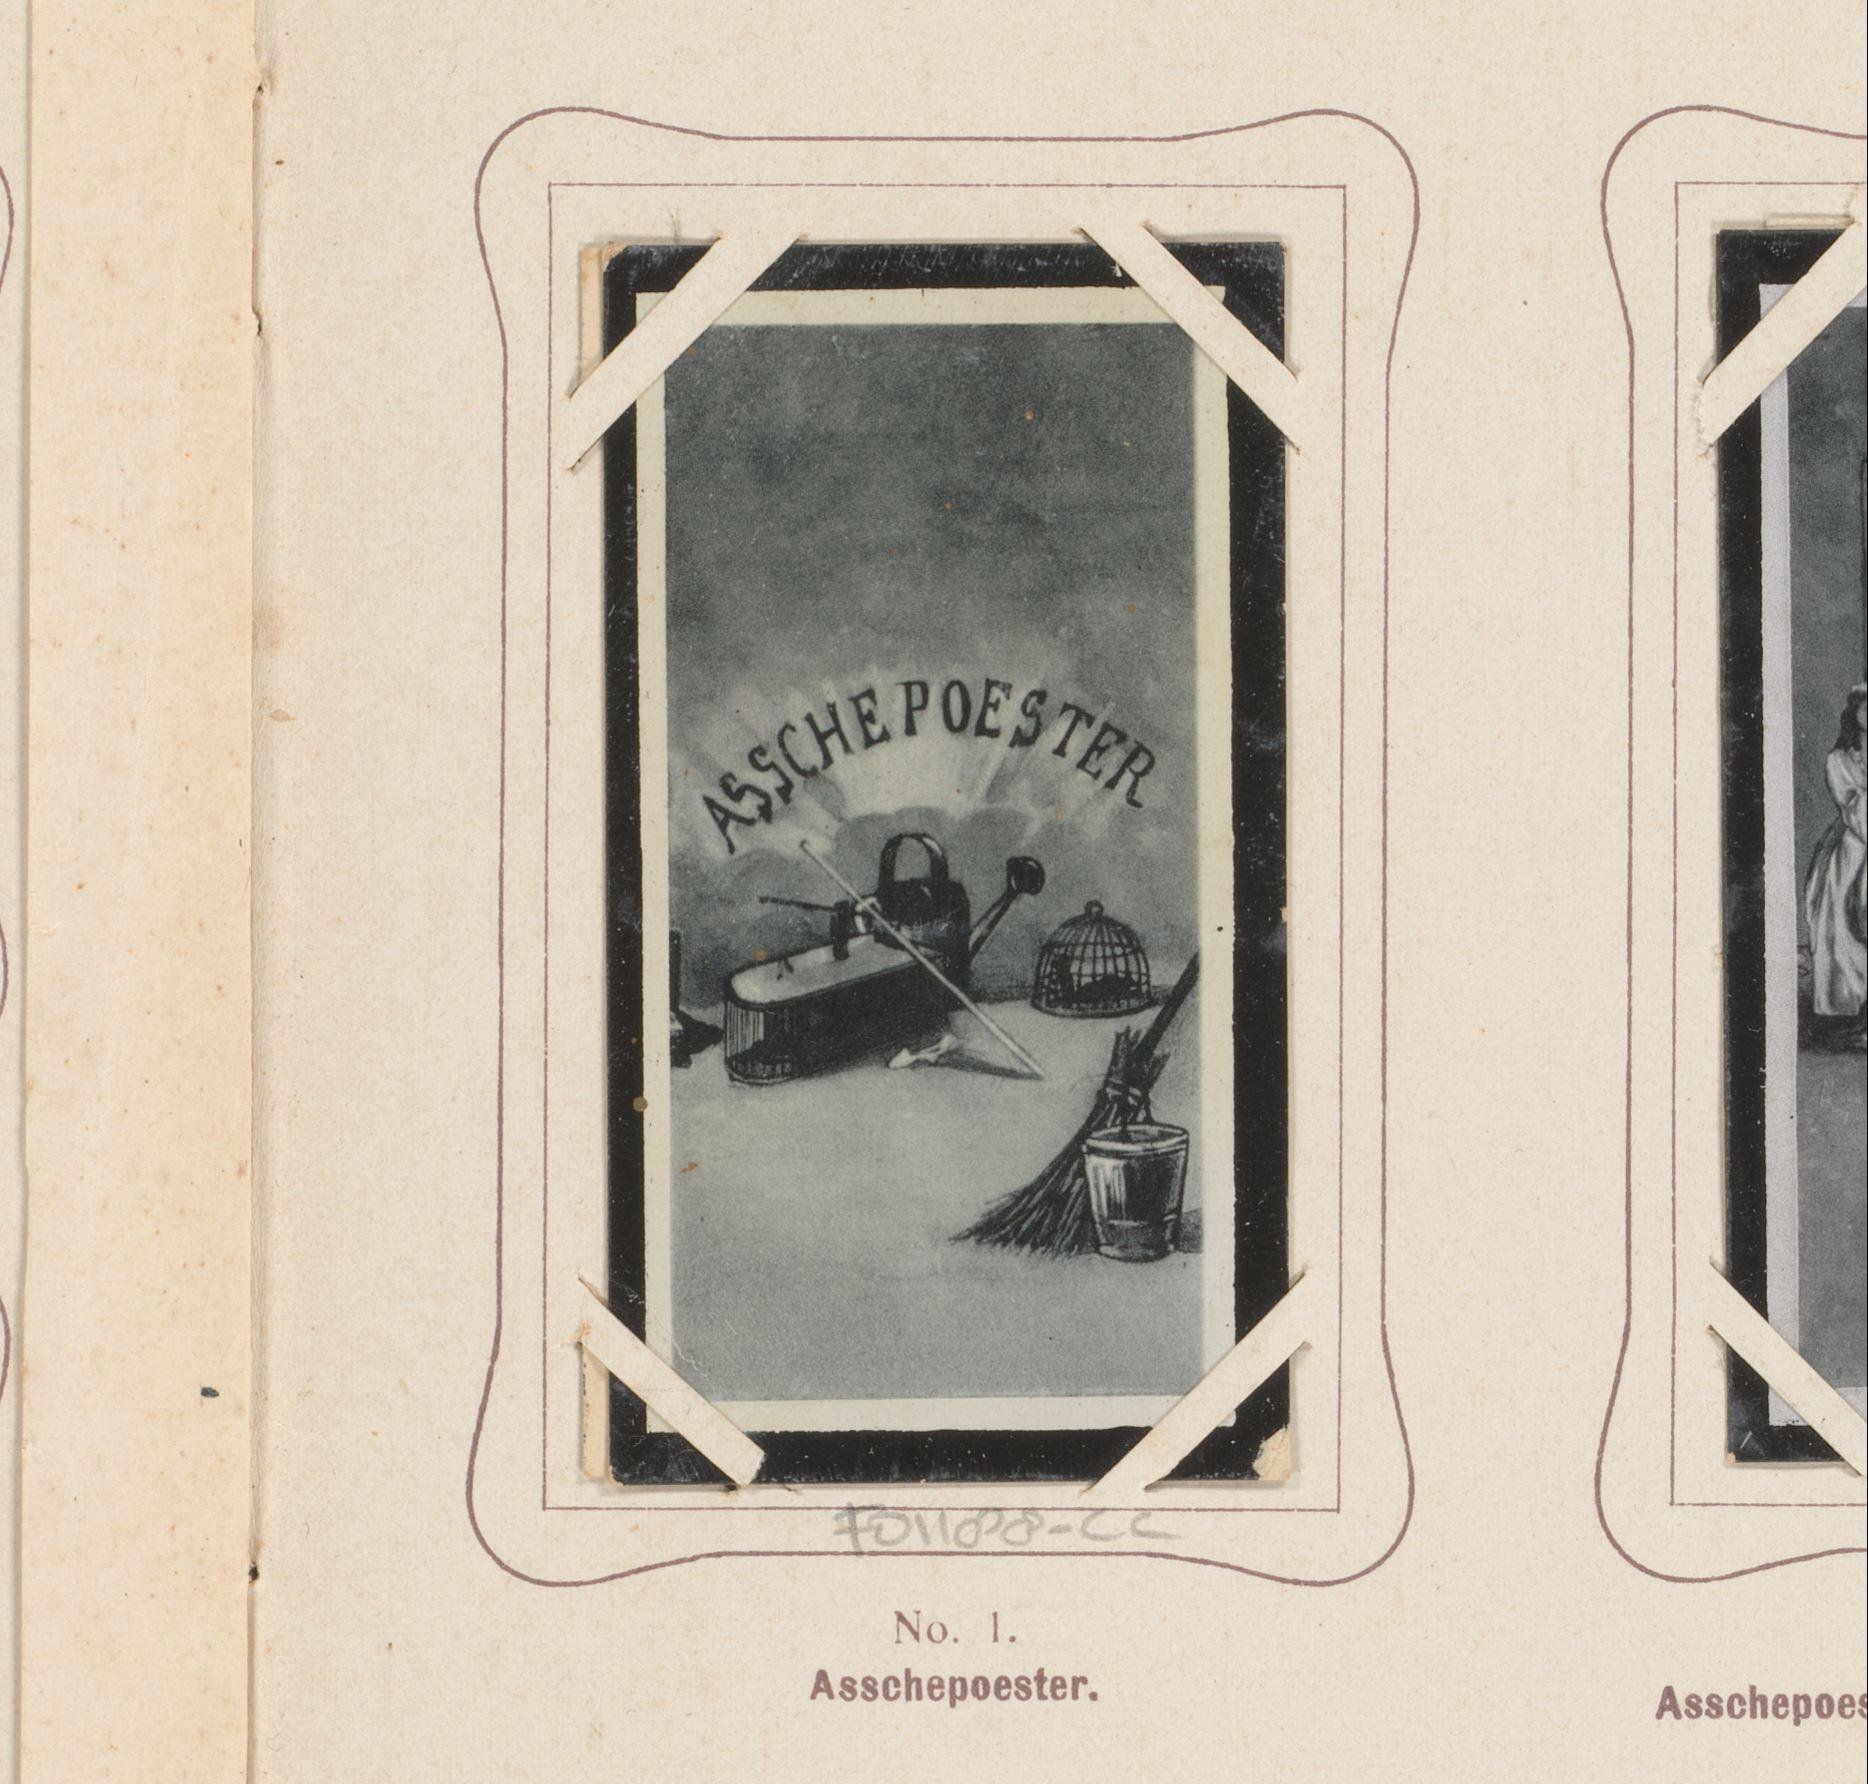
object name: album leaf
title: Reproductie van een tekening met betrekking tot Assepoester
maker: Anonymous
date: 1906-1907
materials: paper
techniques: photograph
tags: tales and fairy tales (with title)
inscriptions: inscription: ‘No. 1./ Asschepoester.’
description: Deze prent maakt deel uit van een album.